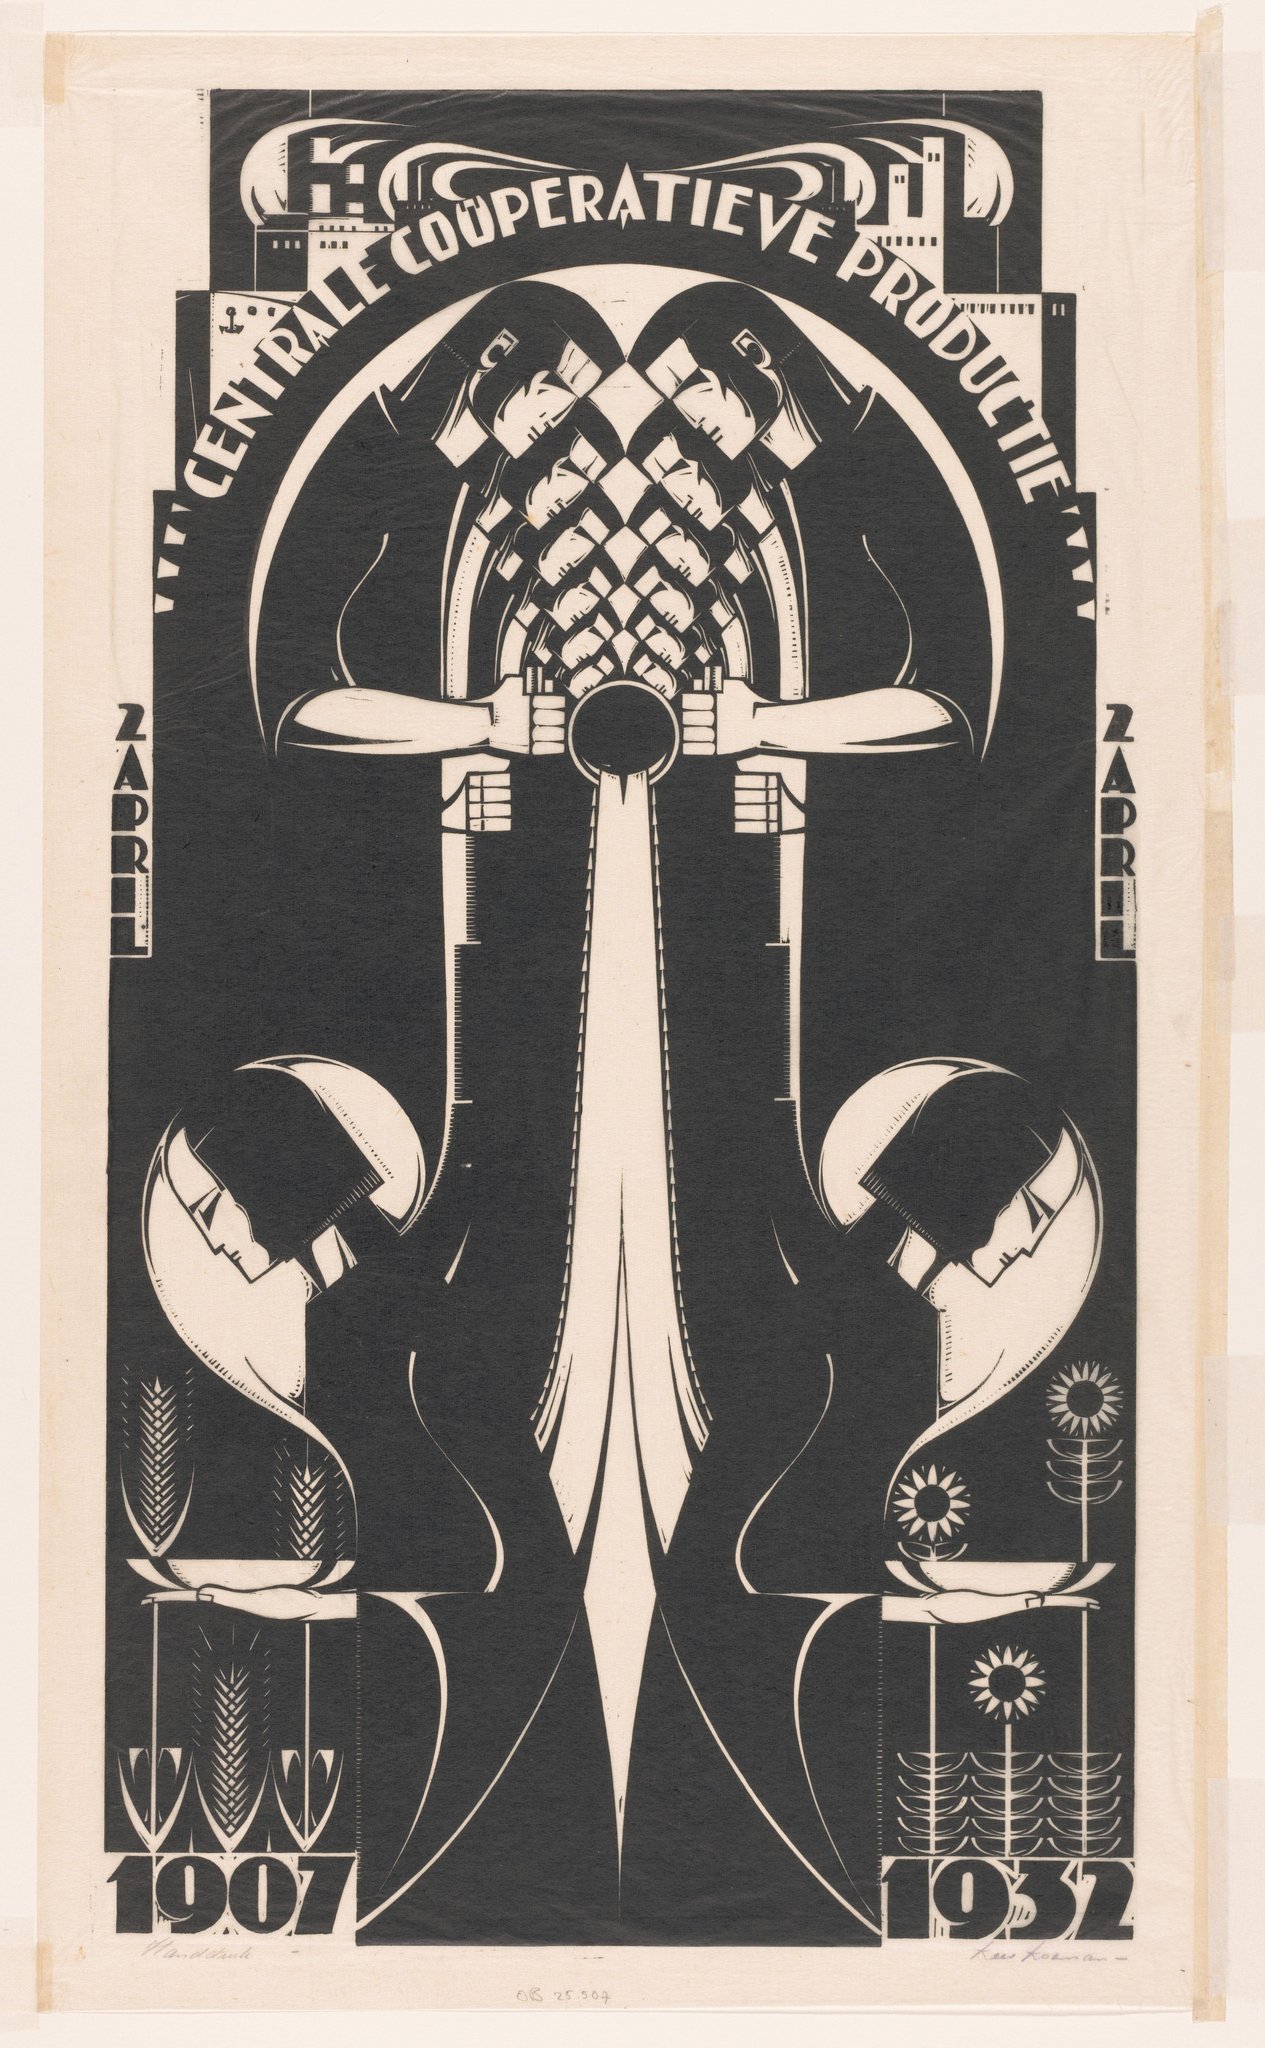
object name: print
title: Centrale coöperatieve productie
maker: kees koeman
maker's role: print maker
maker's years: 1895-1954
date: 1932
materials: paper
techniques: woodcut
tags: working class, labourers